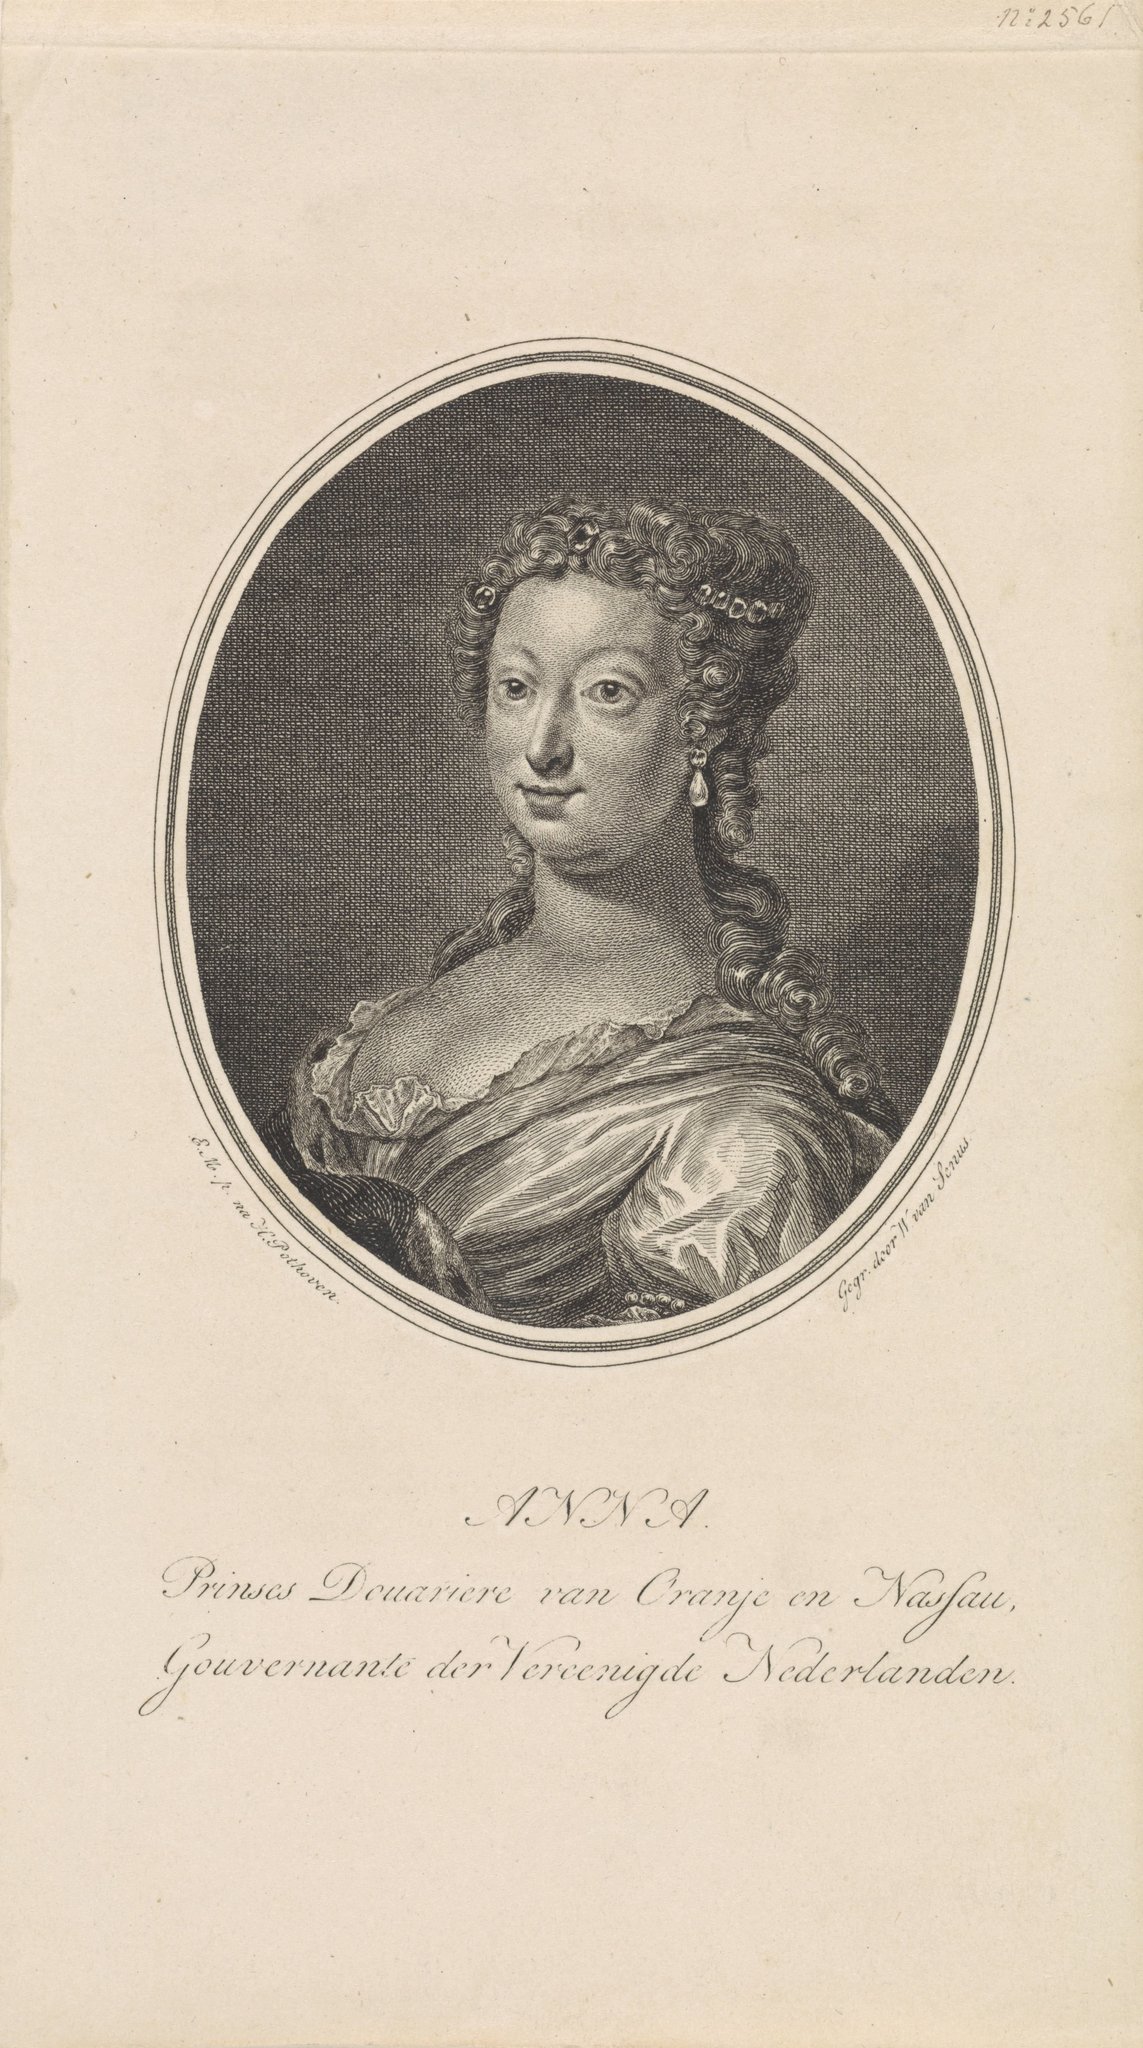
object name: print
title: Portret van Anna, prinses van Oranje Nassau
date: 1783-1851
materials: paper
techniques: engraving, etching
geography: amsterdam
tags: the hague, anna van hannover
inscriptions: collector's mark: Lugt 2228